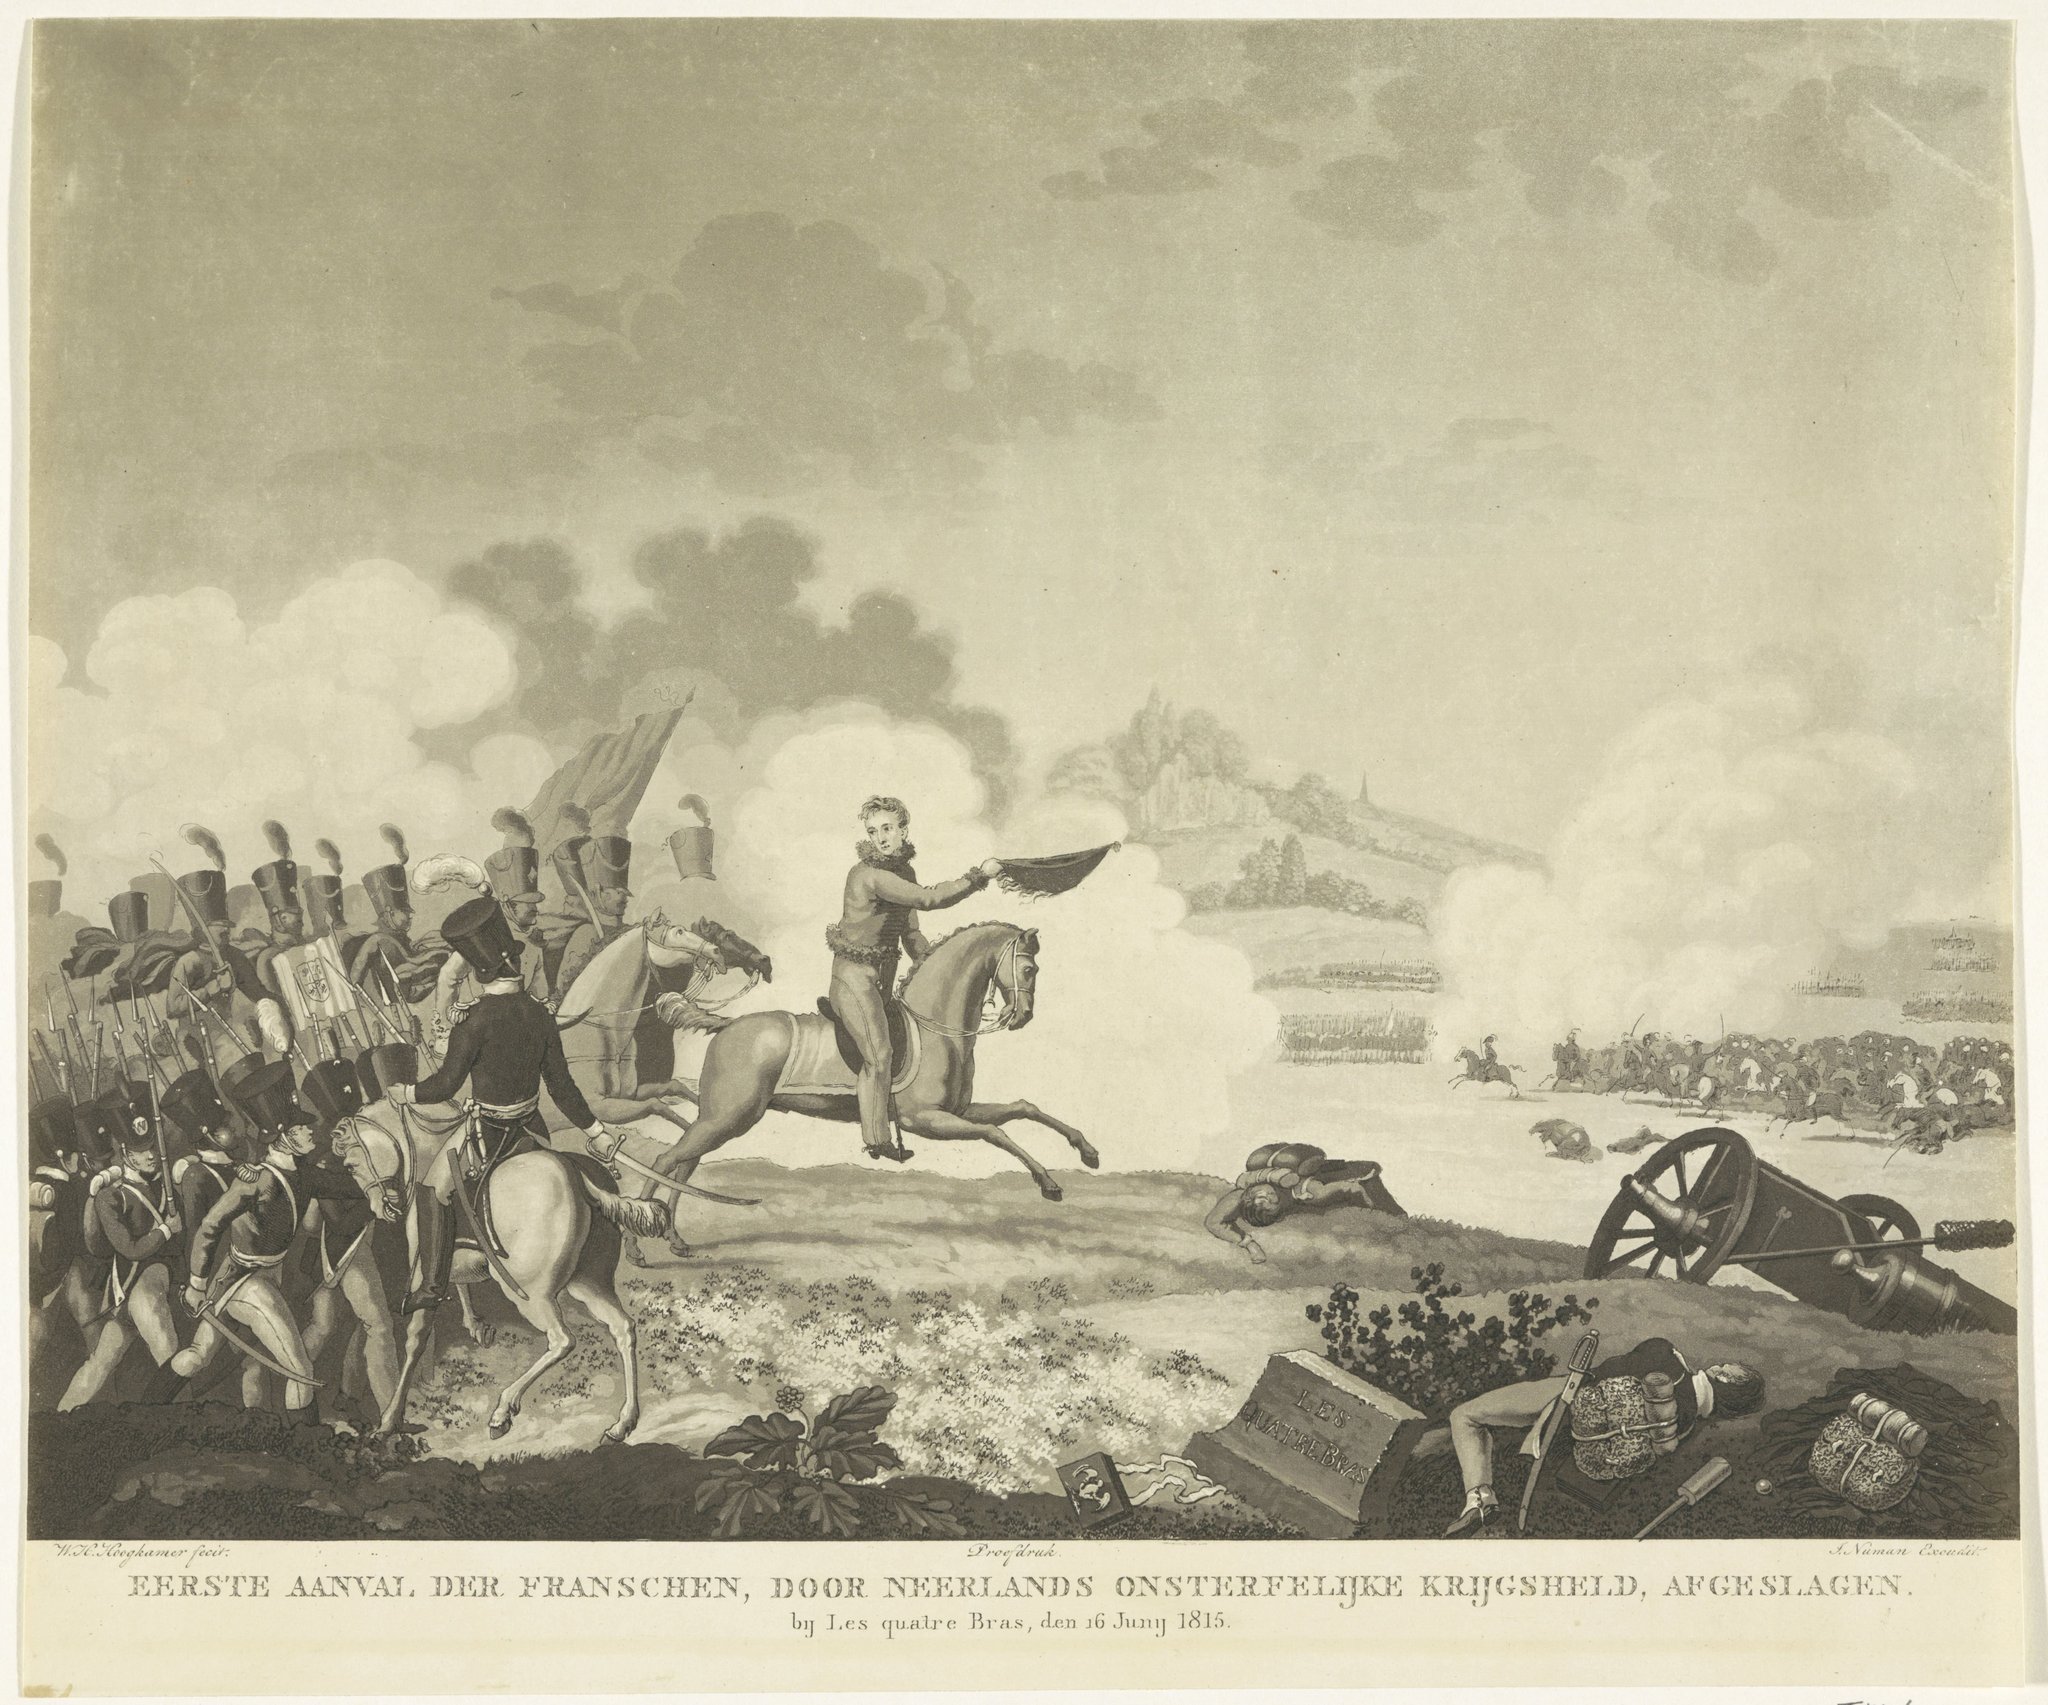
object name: print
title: Eerste serie van vier platen van de veldslagen bij Quatre-Bras en Waterloo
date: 1815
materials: paper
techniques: aquatint, etching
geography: netherlands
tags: the hague, william ii of the netherlands, battle (+ land forces)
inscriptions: collector's mark: Lugt 2228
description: Willem Frederik George, prins van Oranje, leidt de Nederlandse troepen tegen een Franse aanval tijdens de slag bij Quatre-Bras, 16 juni 1815.